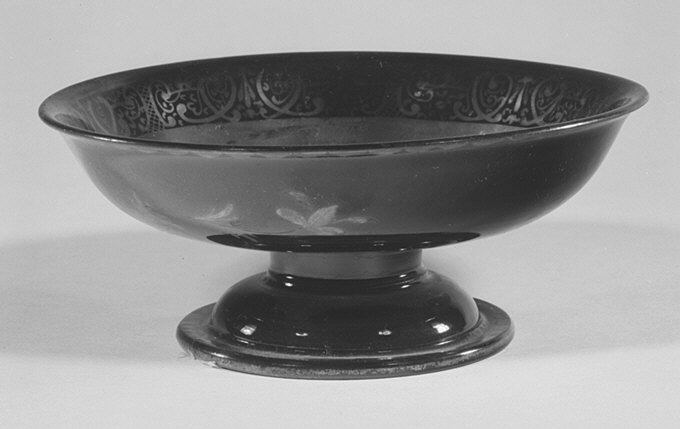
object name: dish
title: Dish (part of a set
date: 1726-1750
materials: earthenware, silver